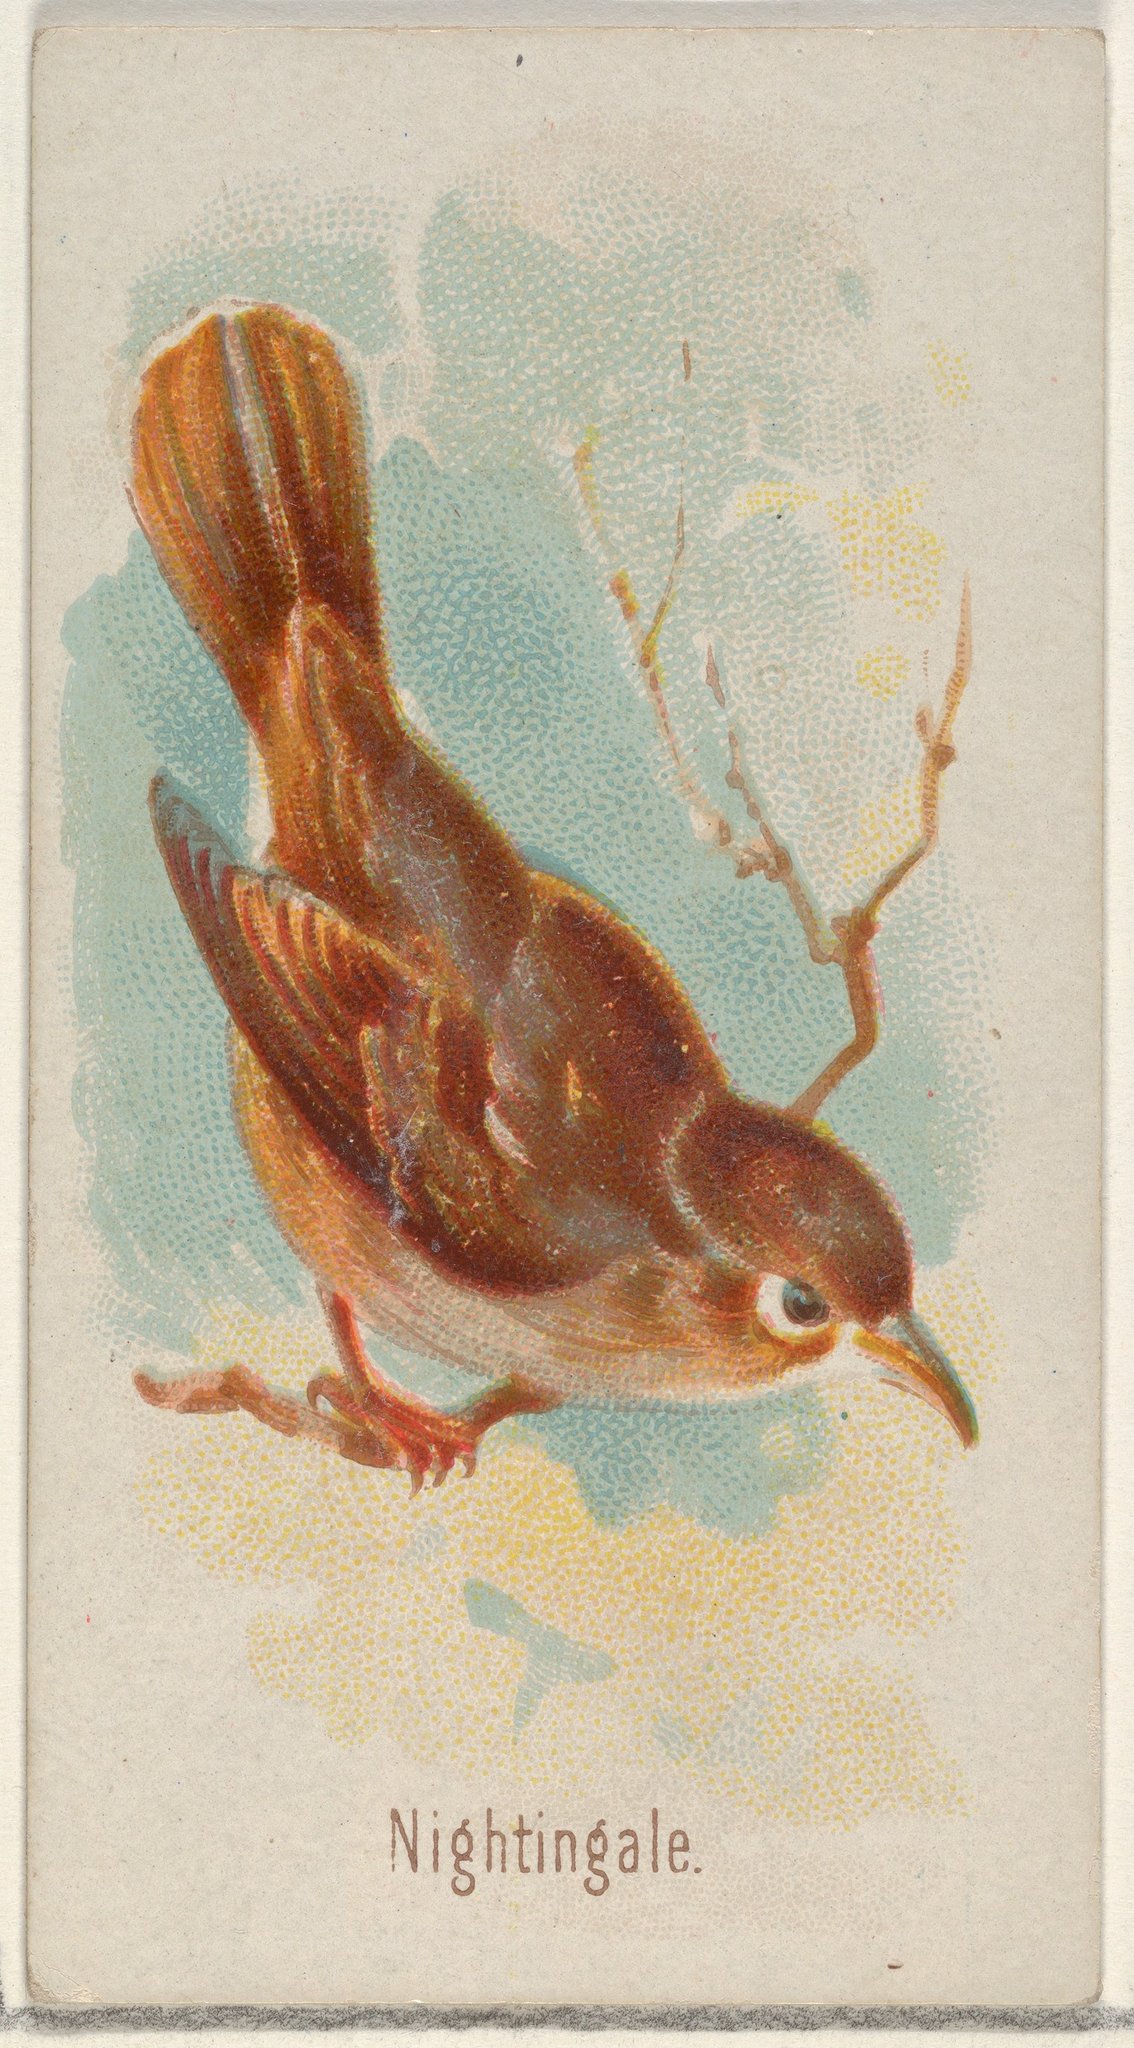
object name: print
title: Nightingale, from the Song Birds of the World series (N23) for Allen & Ginter Cigarettes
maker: allen & ginter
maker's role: publisher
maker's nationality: american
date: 1890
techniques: color lithograph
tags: birds